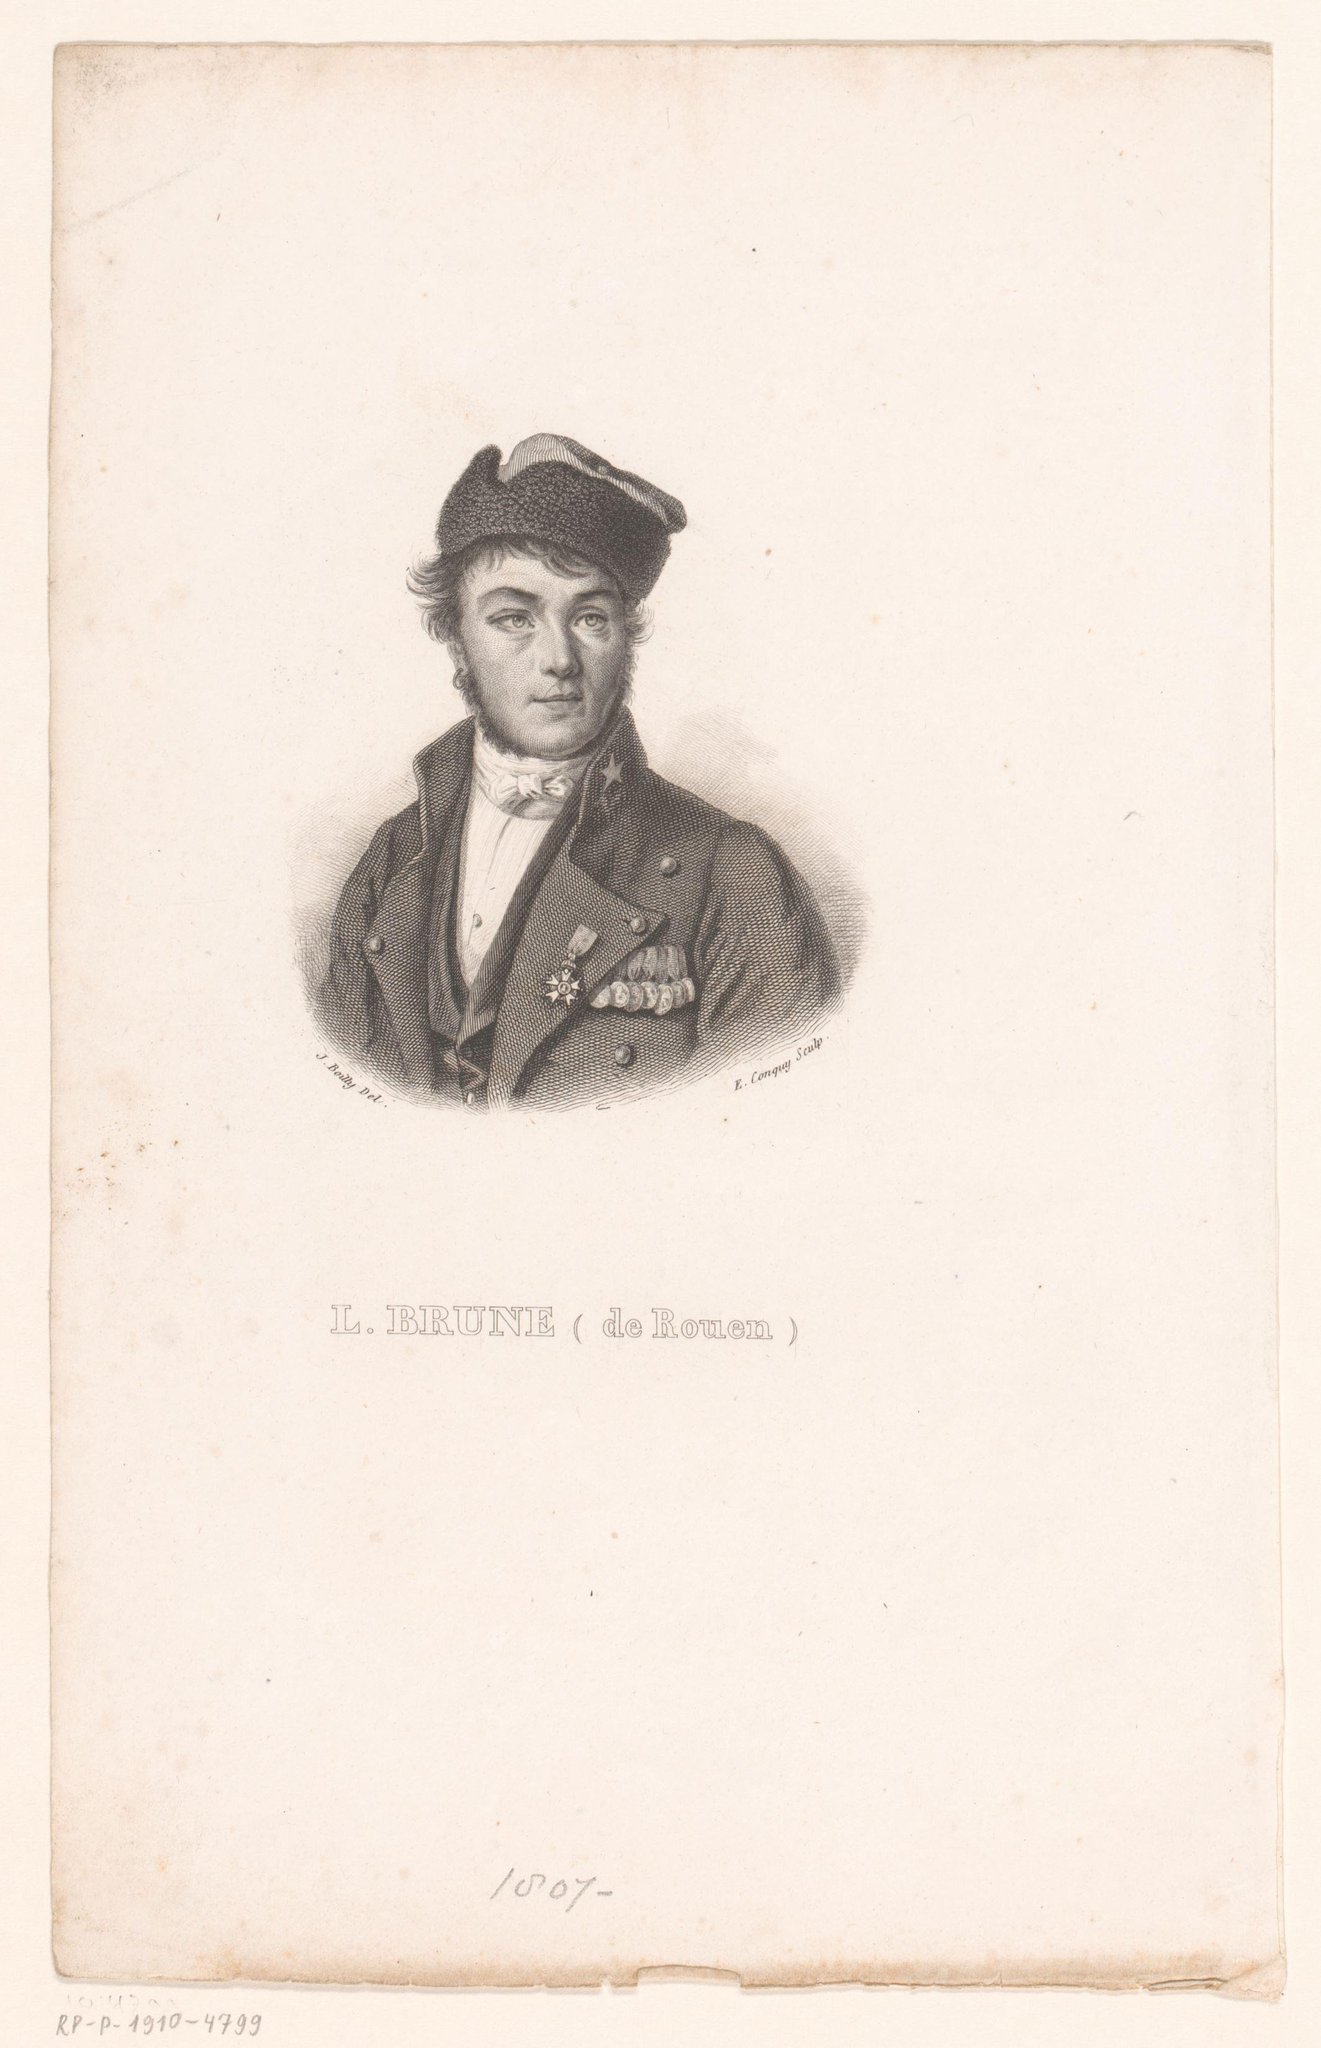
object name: print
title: L. Brune (de Rouen)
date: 1827-1843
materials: paper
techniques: engraving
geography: france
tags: historical persons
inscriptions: collector's mark: Lugt 2228